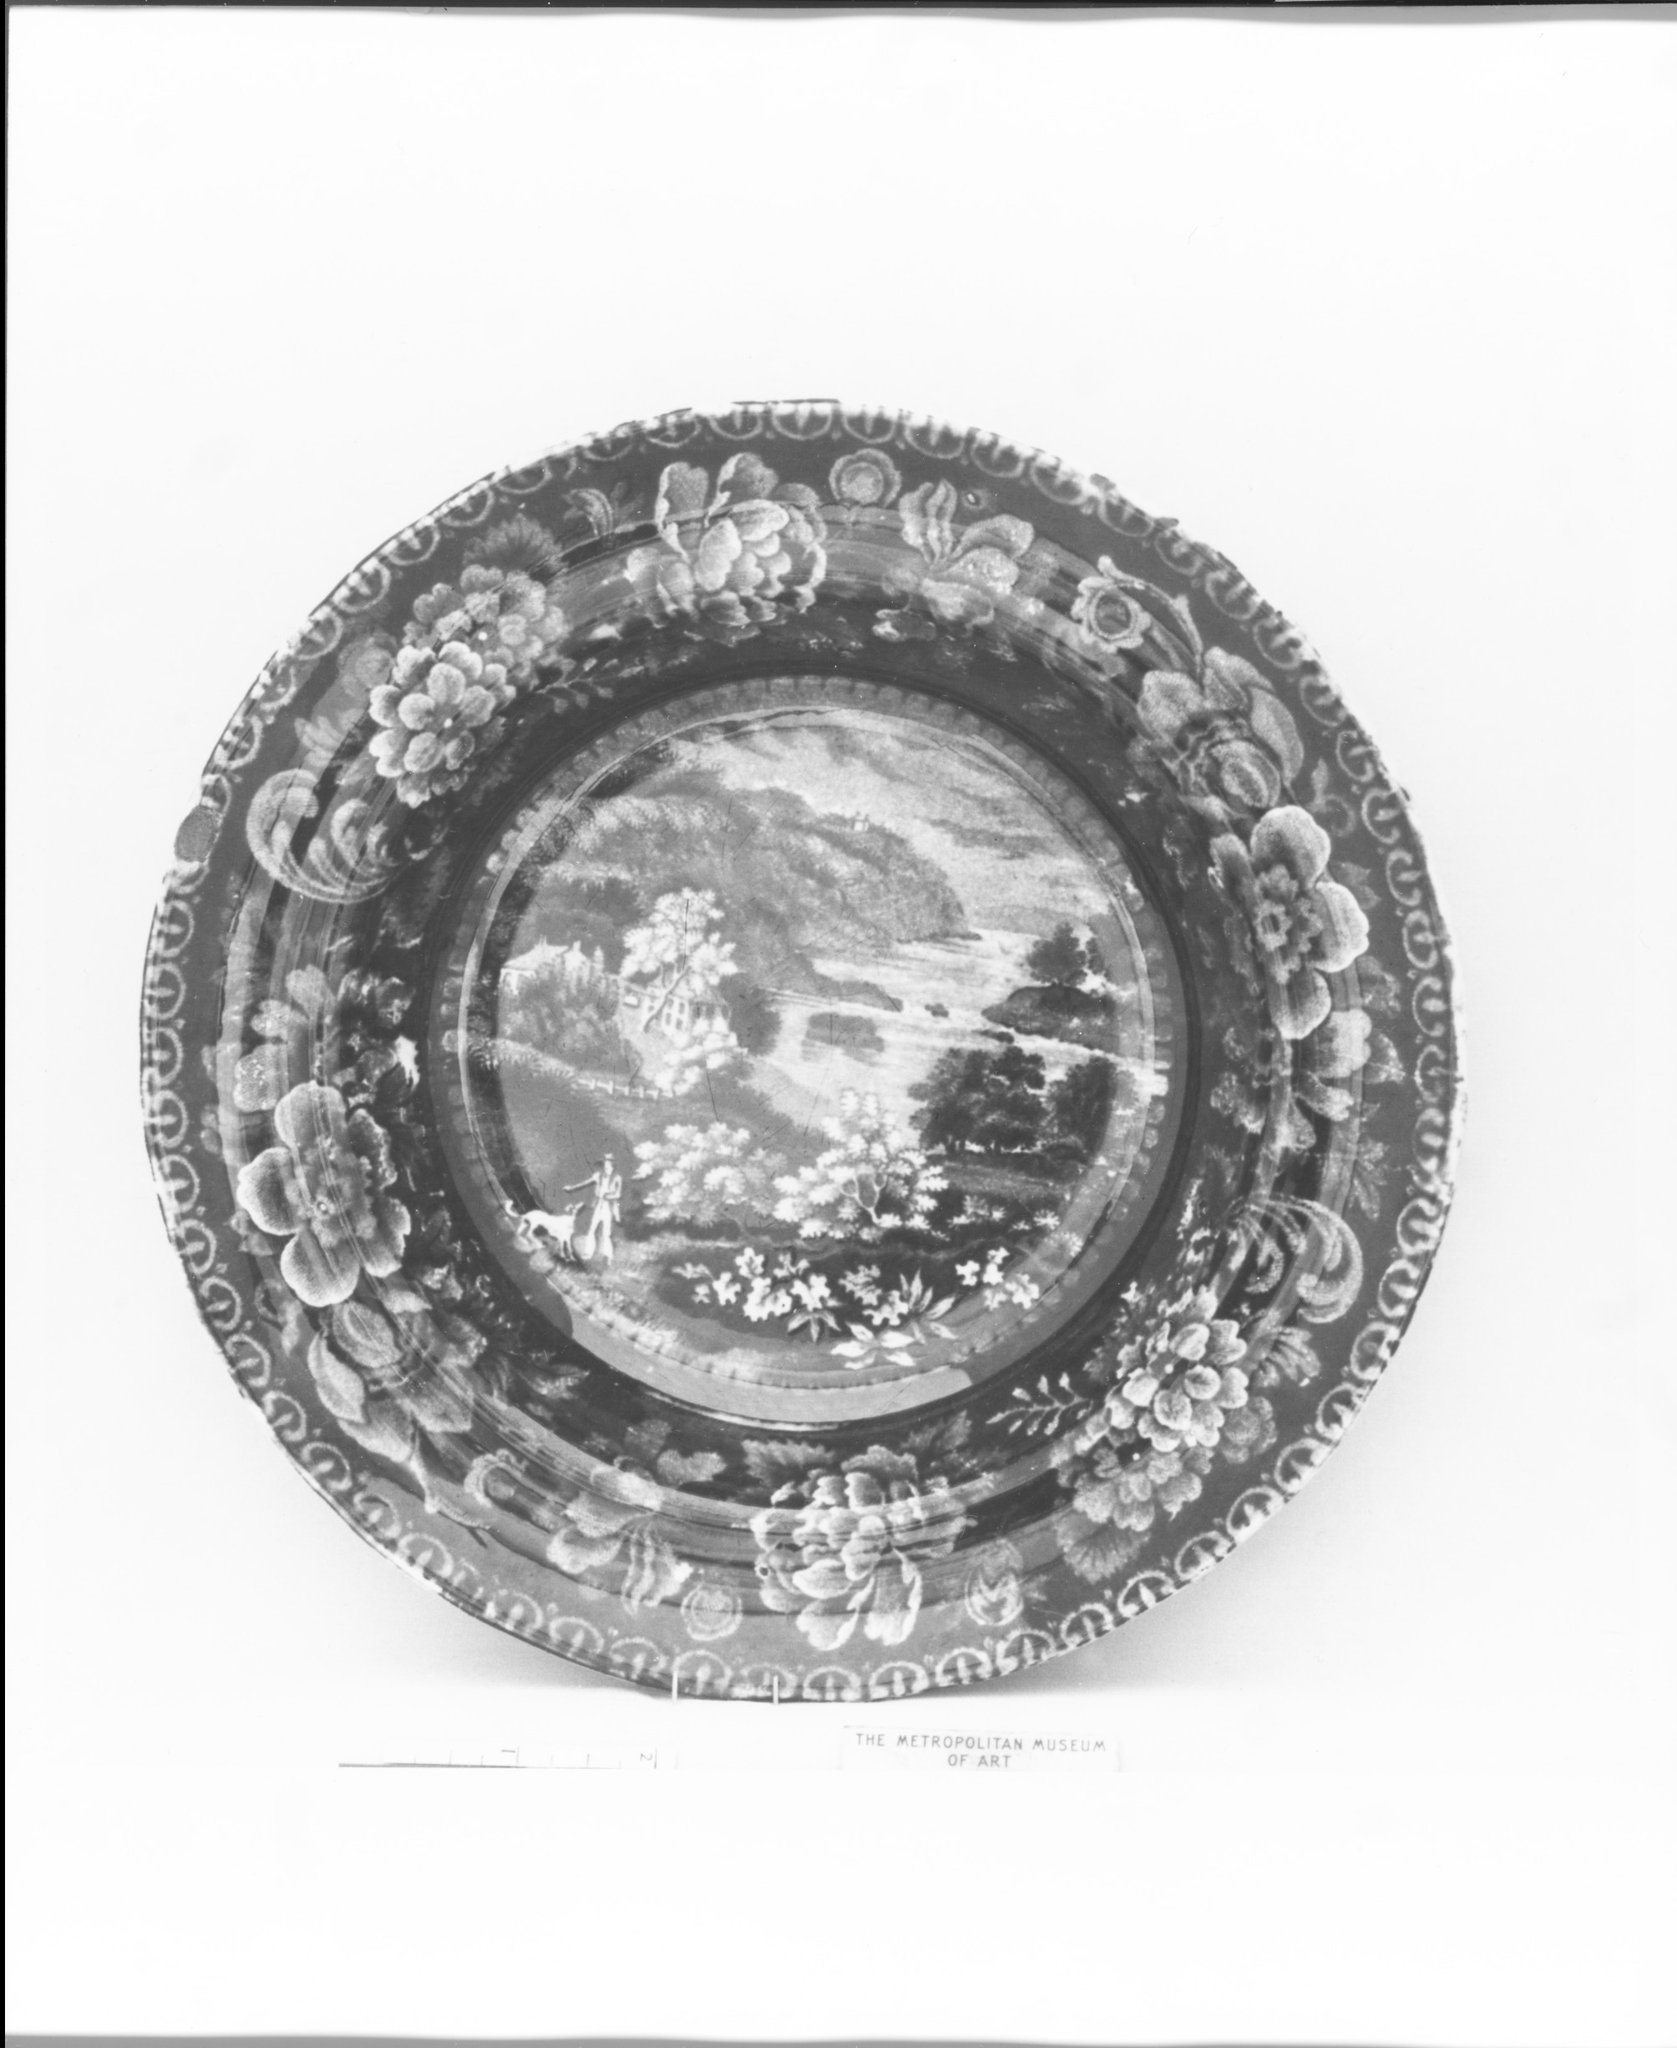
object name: plate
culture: british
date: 1830-1835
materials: earthenware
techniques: transfer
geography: england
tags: flowers,landscapes